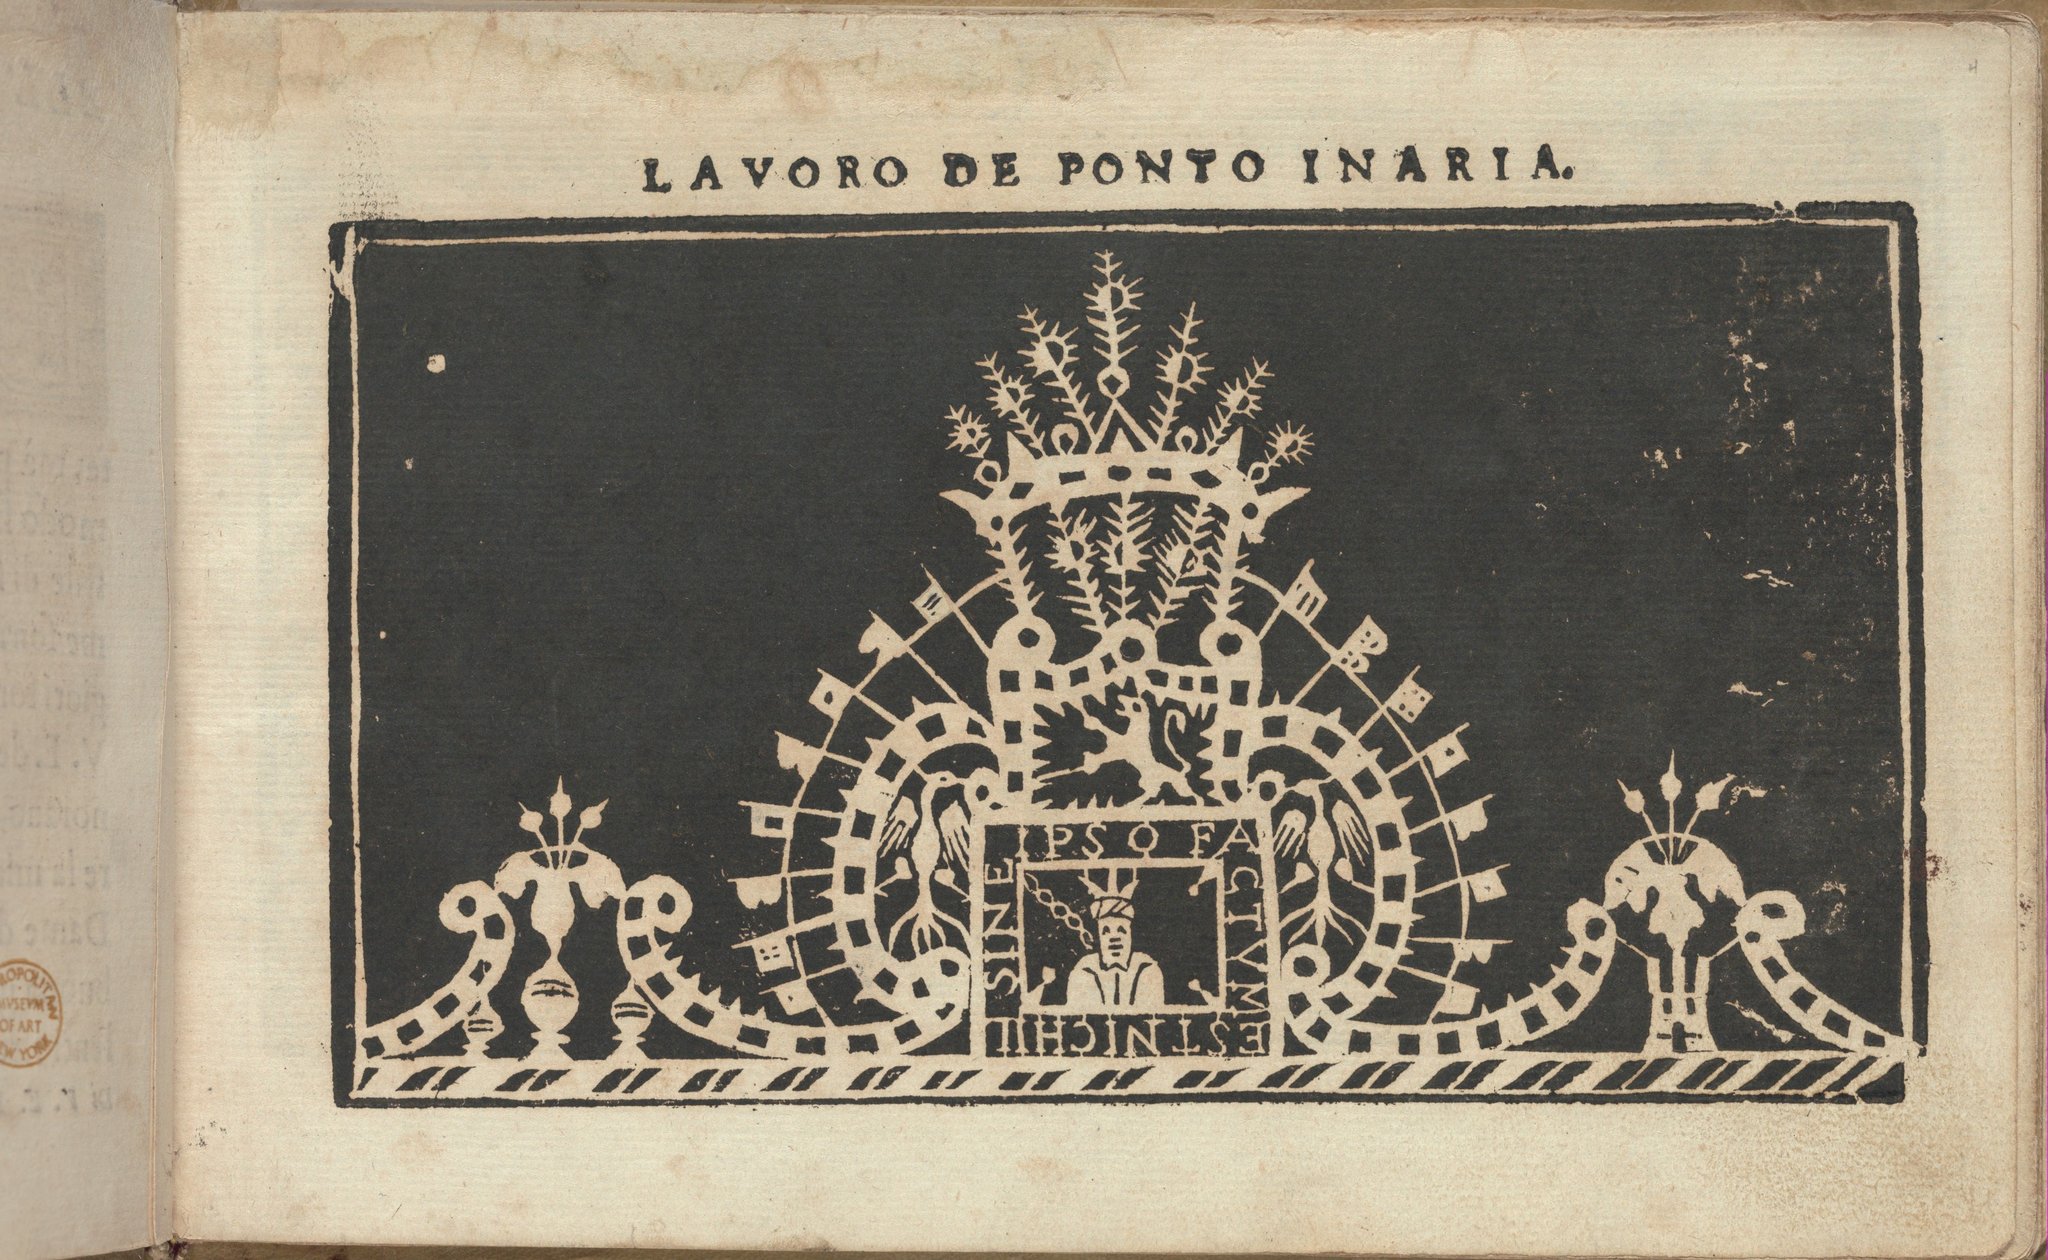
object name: book print ornament architecture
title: Studio delle virtuose Dame, page 4 (recto)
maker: isabella catanea parasole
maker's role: designer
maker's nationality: italian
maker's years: 1565-1625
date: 1597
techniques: woodcut